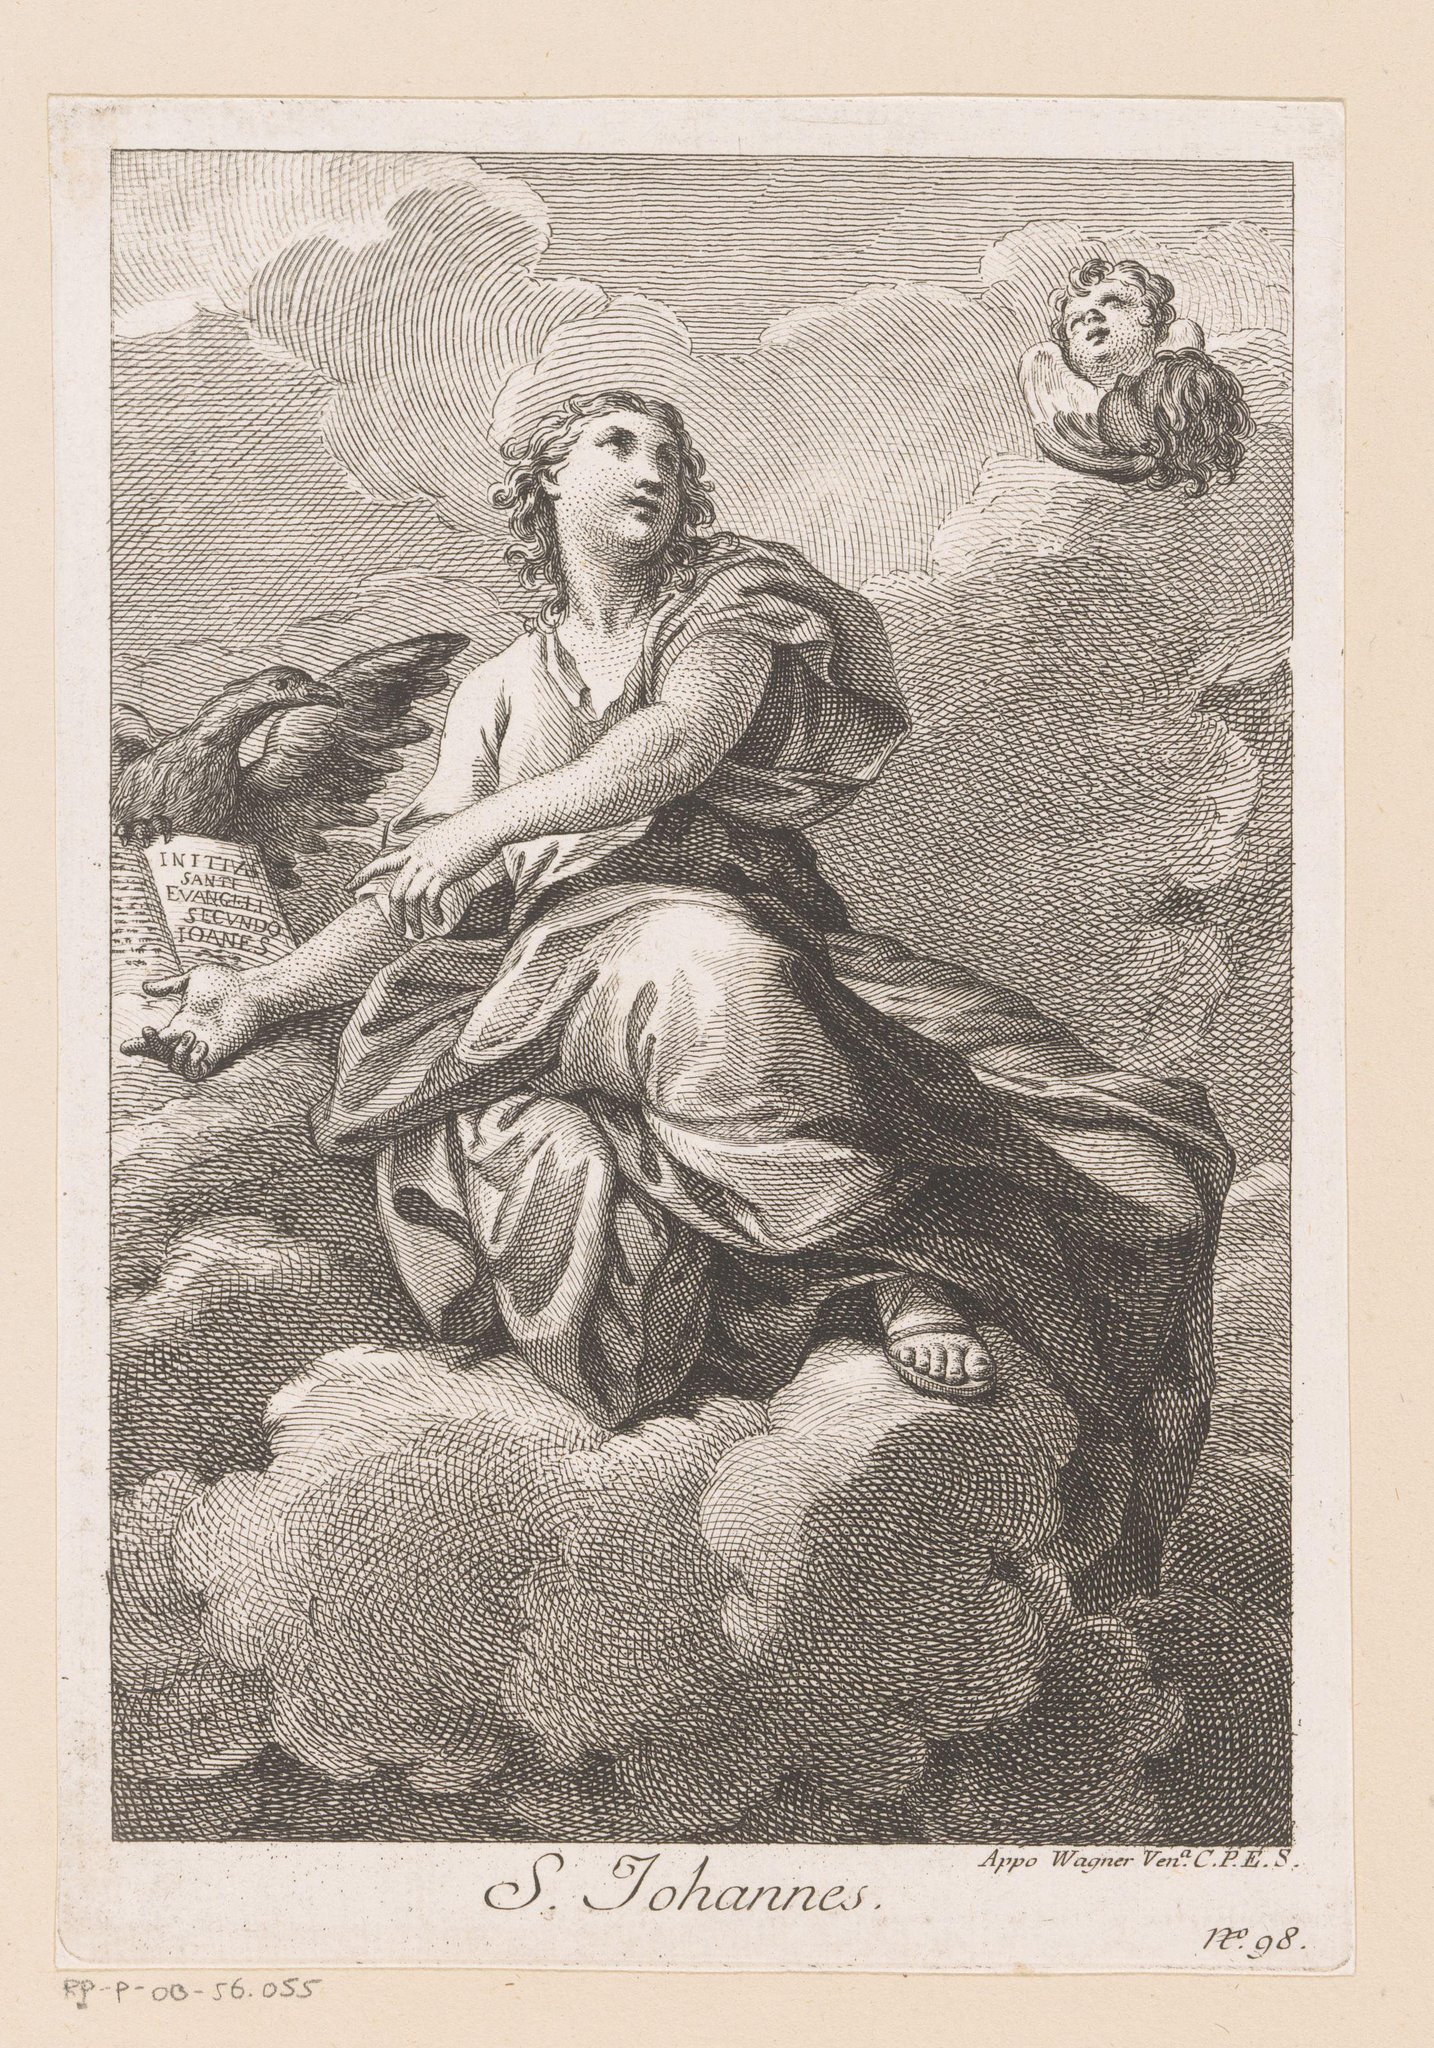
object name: print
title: Johannes de evangelist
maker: joseph wagner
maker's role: painter, print maker, publisher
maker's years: 1706-1780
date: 1739-1780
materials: paper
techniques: etching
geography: venice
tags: the apostle john the evangelist; possible attributes: book, cauldron, chalice with snake, eagle, palm, scroll